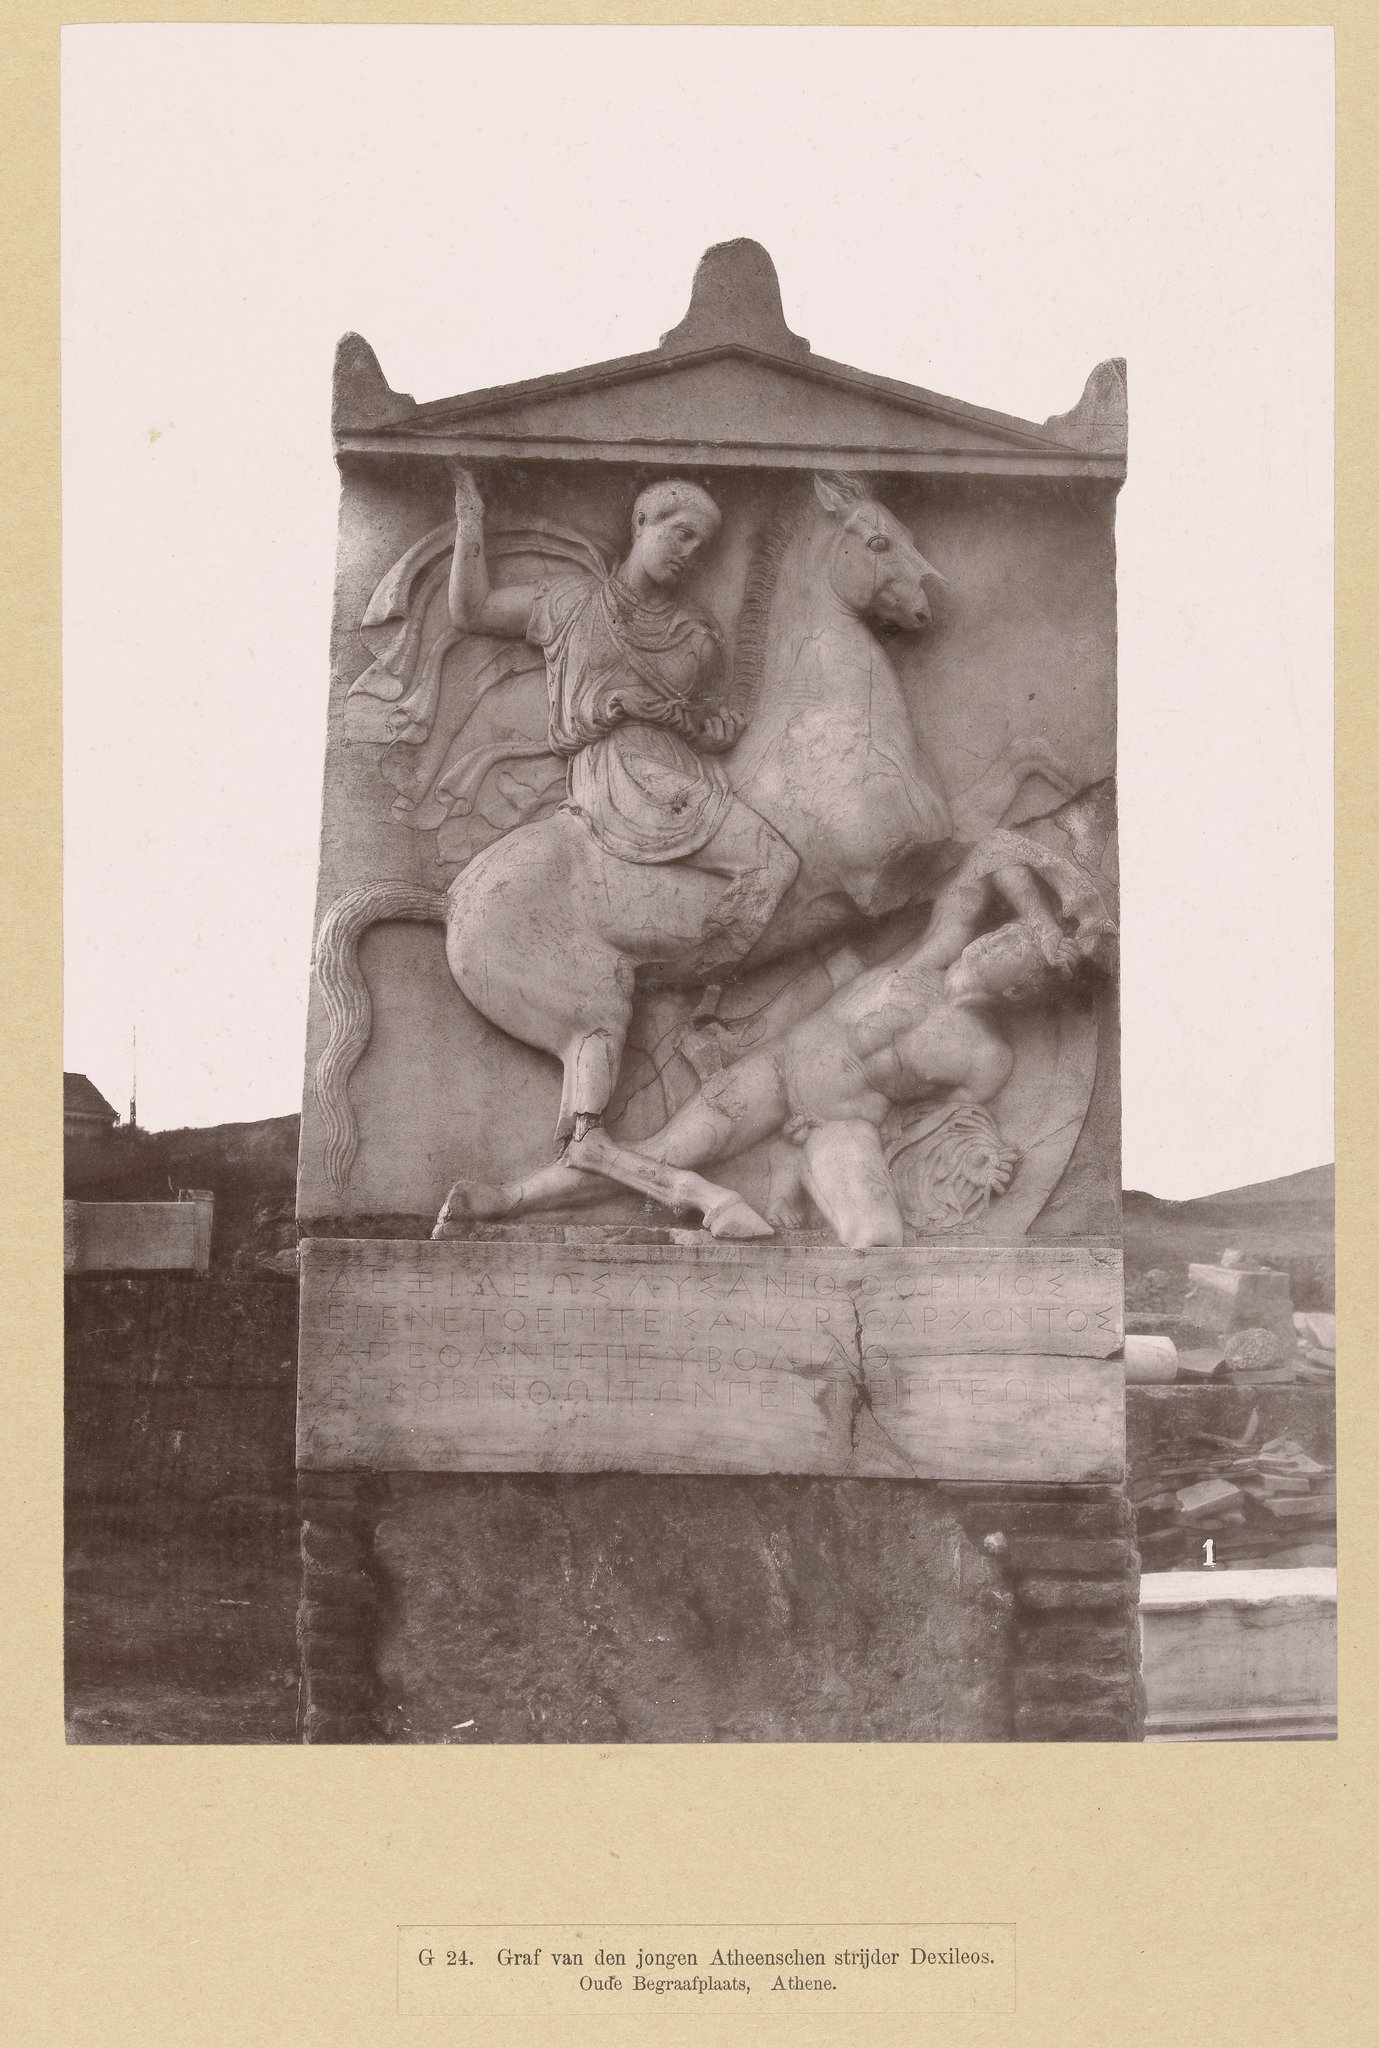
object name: photomechanical print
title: G 24. Graf van den jongen Atheenschen strijder Dexileos. Oude Begraafplaats, Athene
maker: Anonymous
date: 1890-1895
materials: cardboard, paper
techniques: photograph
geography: athens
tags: piece of sculpture, reproduction of a piece of sculpture, gravestone, tombstone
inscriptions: stamp: ‘Gemeentelijke bibliotheek/ Rotterdam’, number: ‘1’, title: ‘G 24. Graf van den jongen Atheenschen strijder Dexileos./ Oude Begraafplaats, Athene.’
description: Onderdeel van een groep door fotograaf Richard Polak op reis verzamelde foto’s. Deze fotomechanische afdruk is samen met andere op zijn reizen verzamelde foto's tentoongesteld bij de Rotterdamsche Kunstkring (1895), Arti en Amicitiae te Amsterdam (1897-1898?) en Societeit 't Collegie te Kampen (datum vooralsnog onbekend).